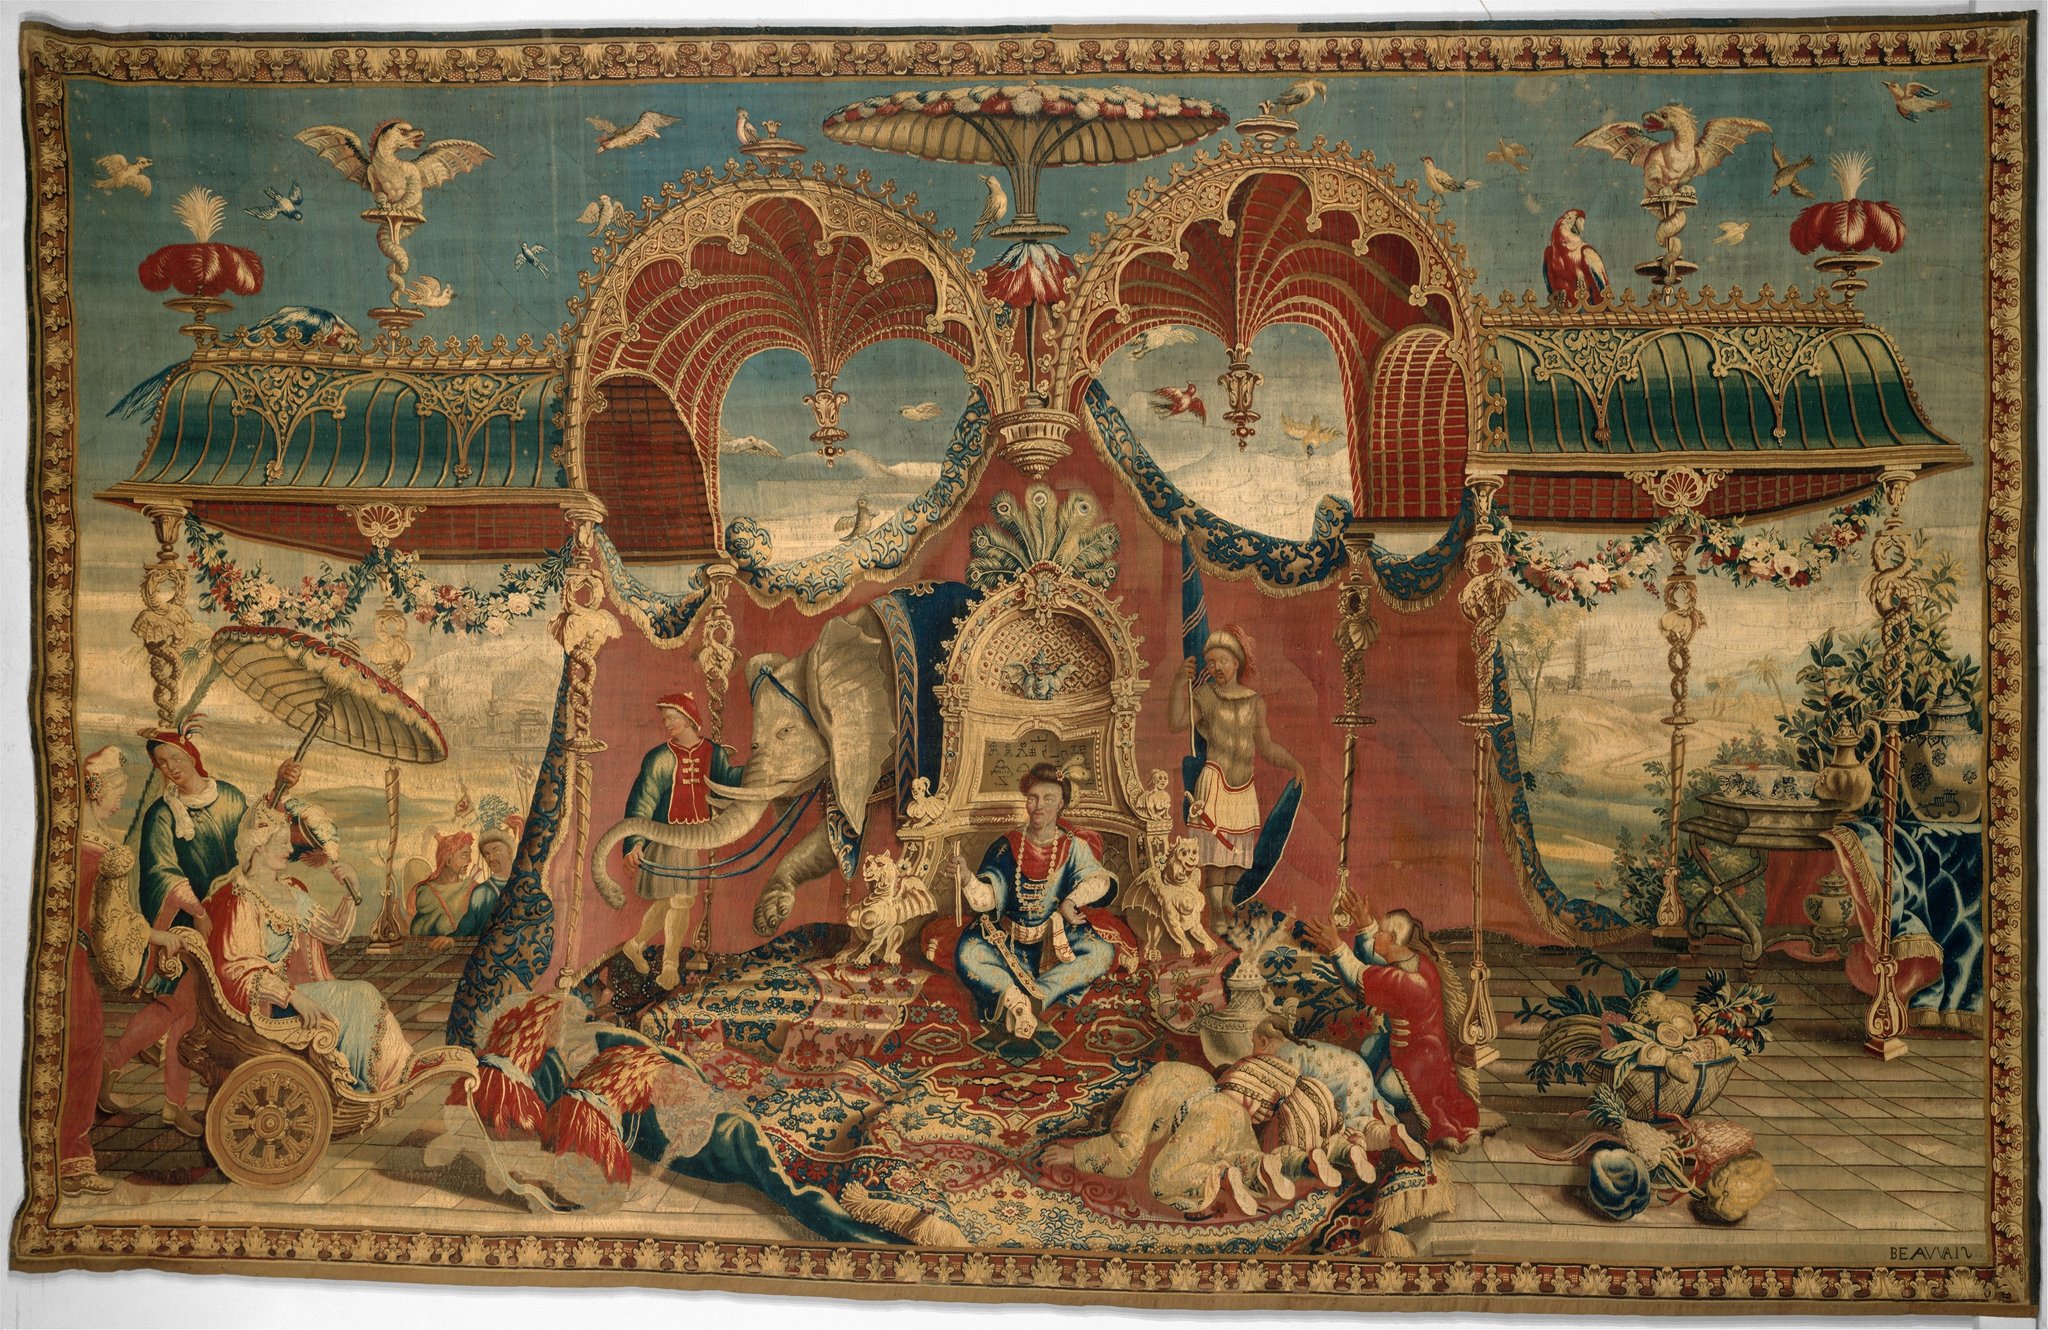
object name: tapestry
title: The Audience of the Emperor from the series The Story of the Emperor of China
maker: guy louis vernansal the elder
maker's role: designer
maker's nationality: french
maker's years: 1648-1729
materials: silk, wool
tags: birds,chinoiserie,fruit,men,women,elephants